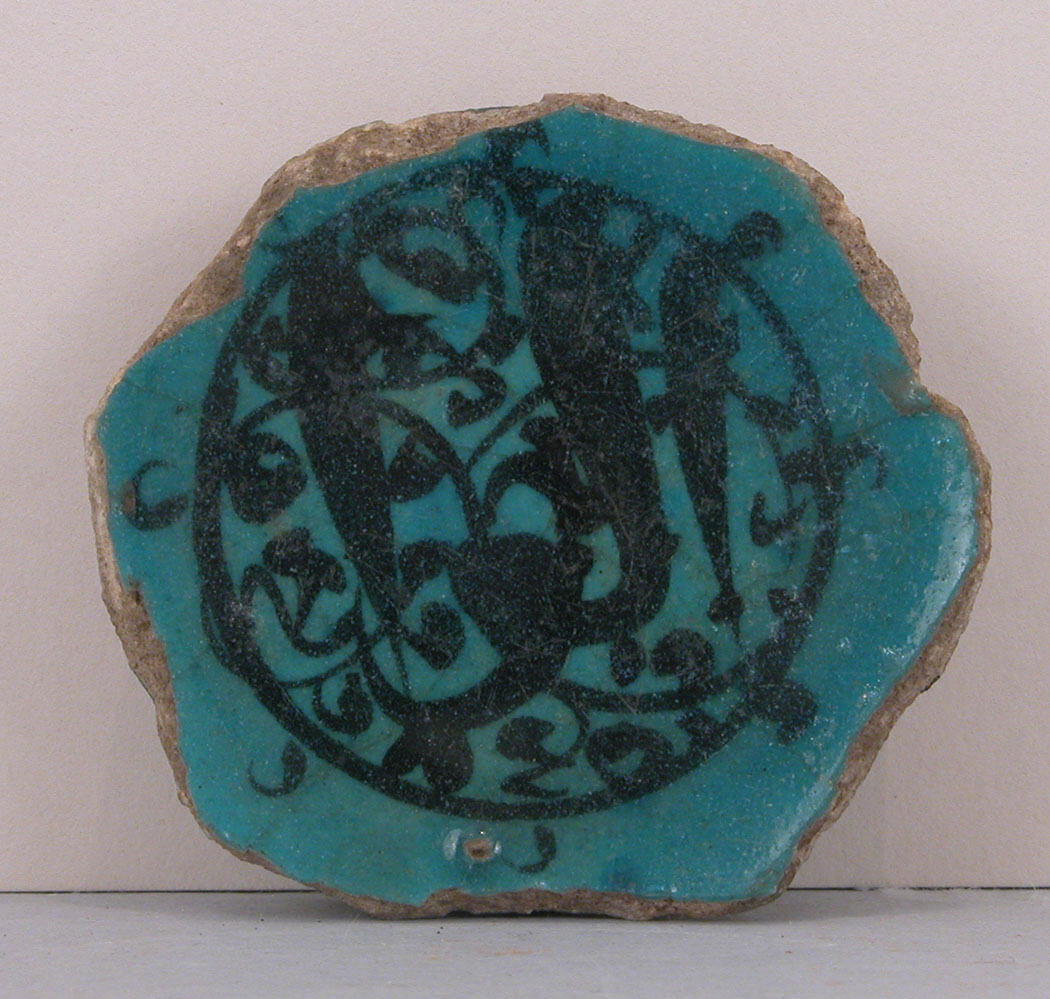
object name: fragment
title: Fragment of a Bowl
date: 1201-1300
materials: stonepaste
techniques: painting, underglaze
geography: syria